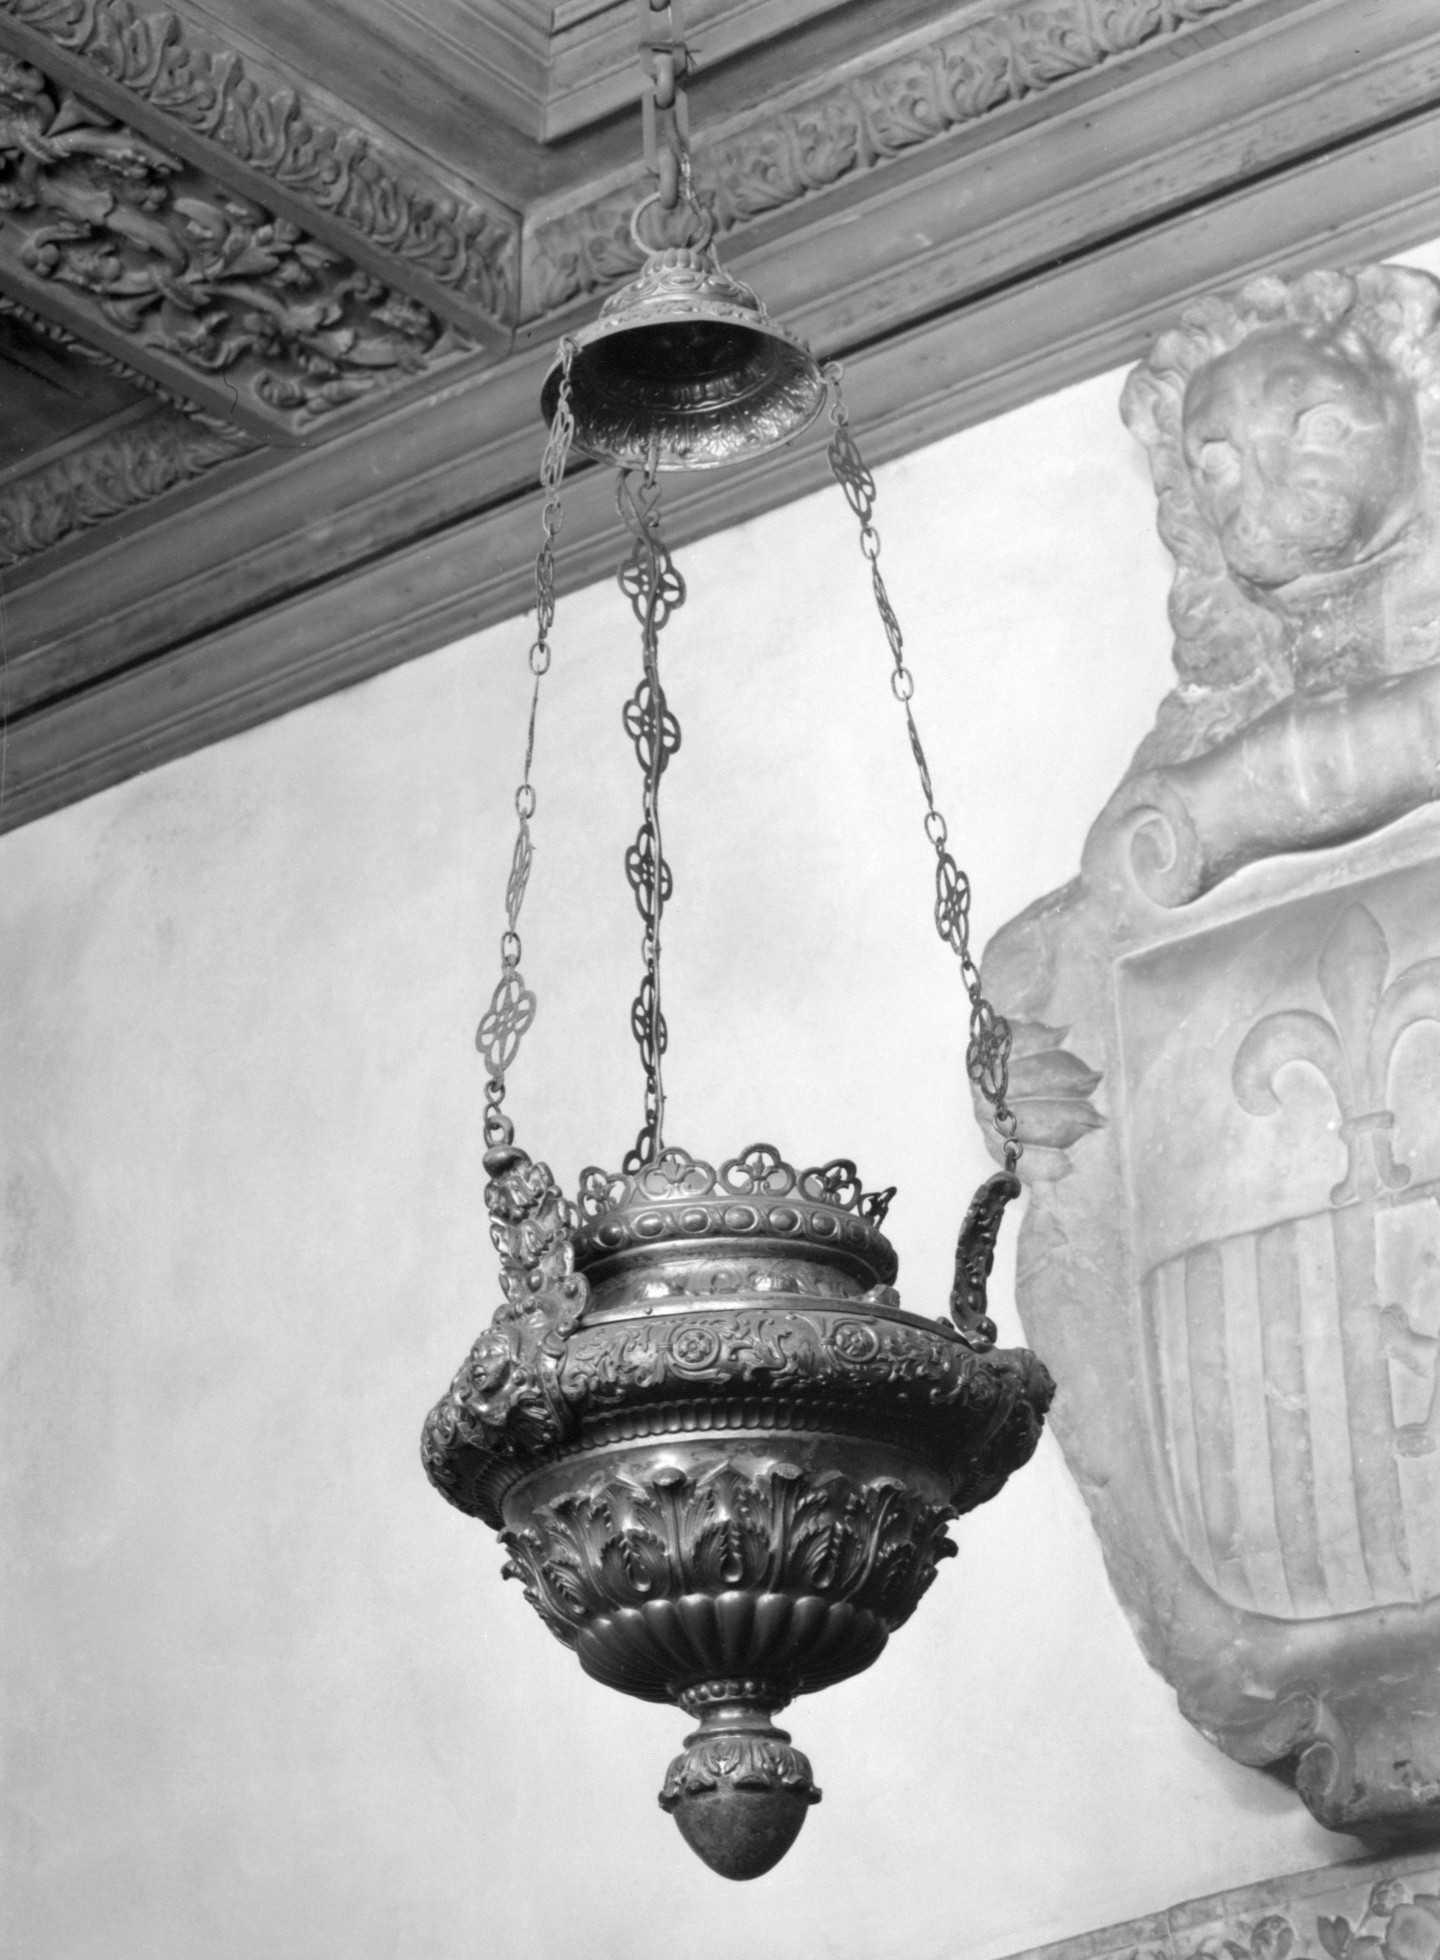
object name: sanctuary lamp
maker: gennaro romanelli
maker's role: maker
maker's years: 1809-1840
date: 1839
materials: silver